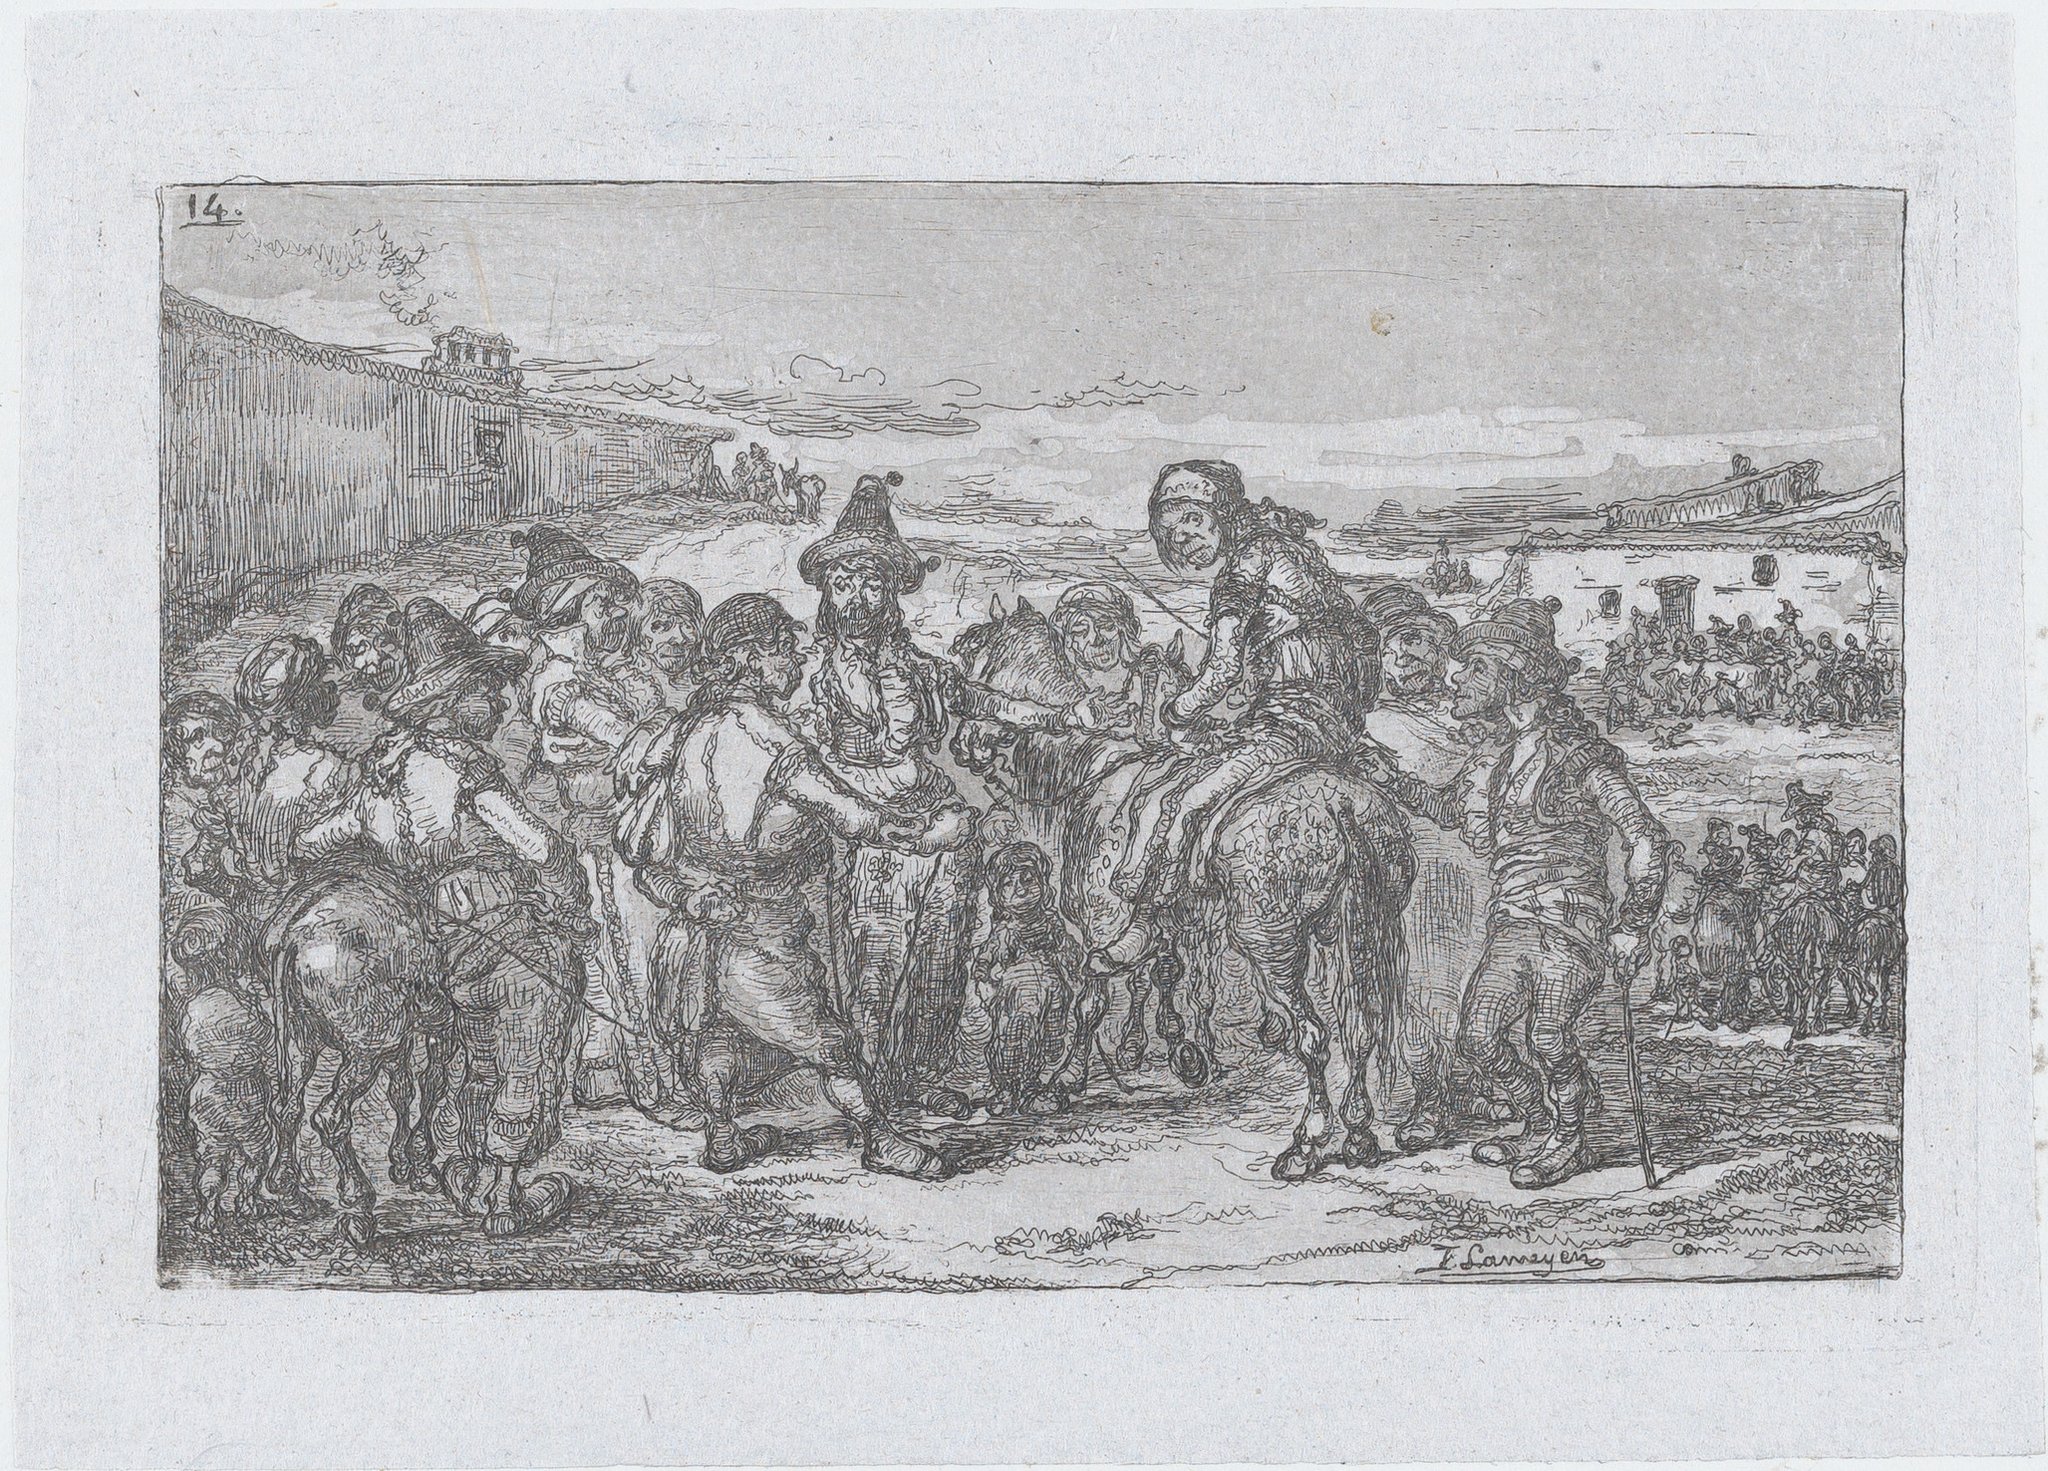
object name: print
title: Plate 14: a large group of people outdoors, possibly a troupe of actors, from the series of customs and pastimes of the Spanish people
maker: francisco lameyer y berenguer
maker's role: artist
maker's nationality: spanish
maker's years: 1825-1877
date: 1850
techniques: aquatint, etching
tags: men,horses,crowd